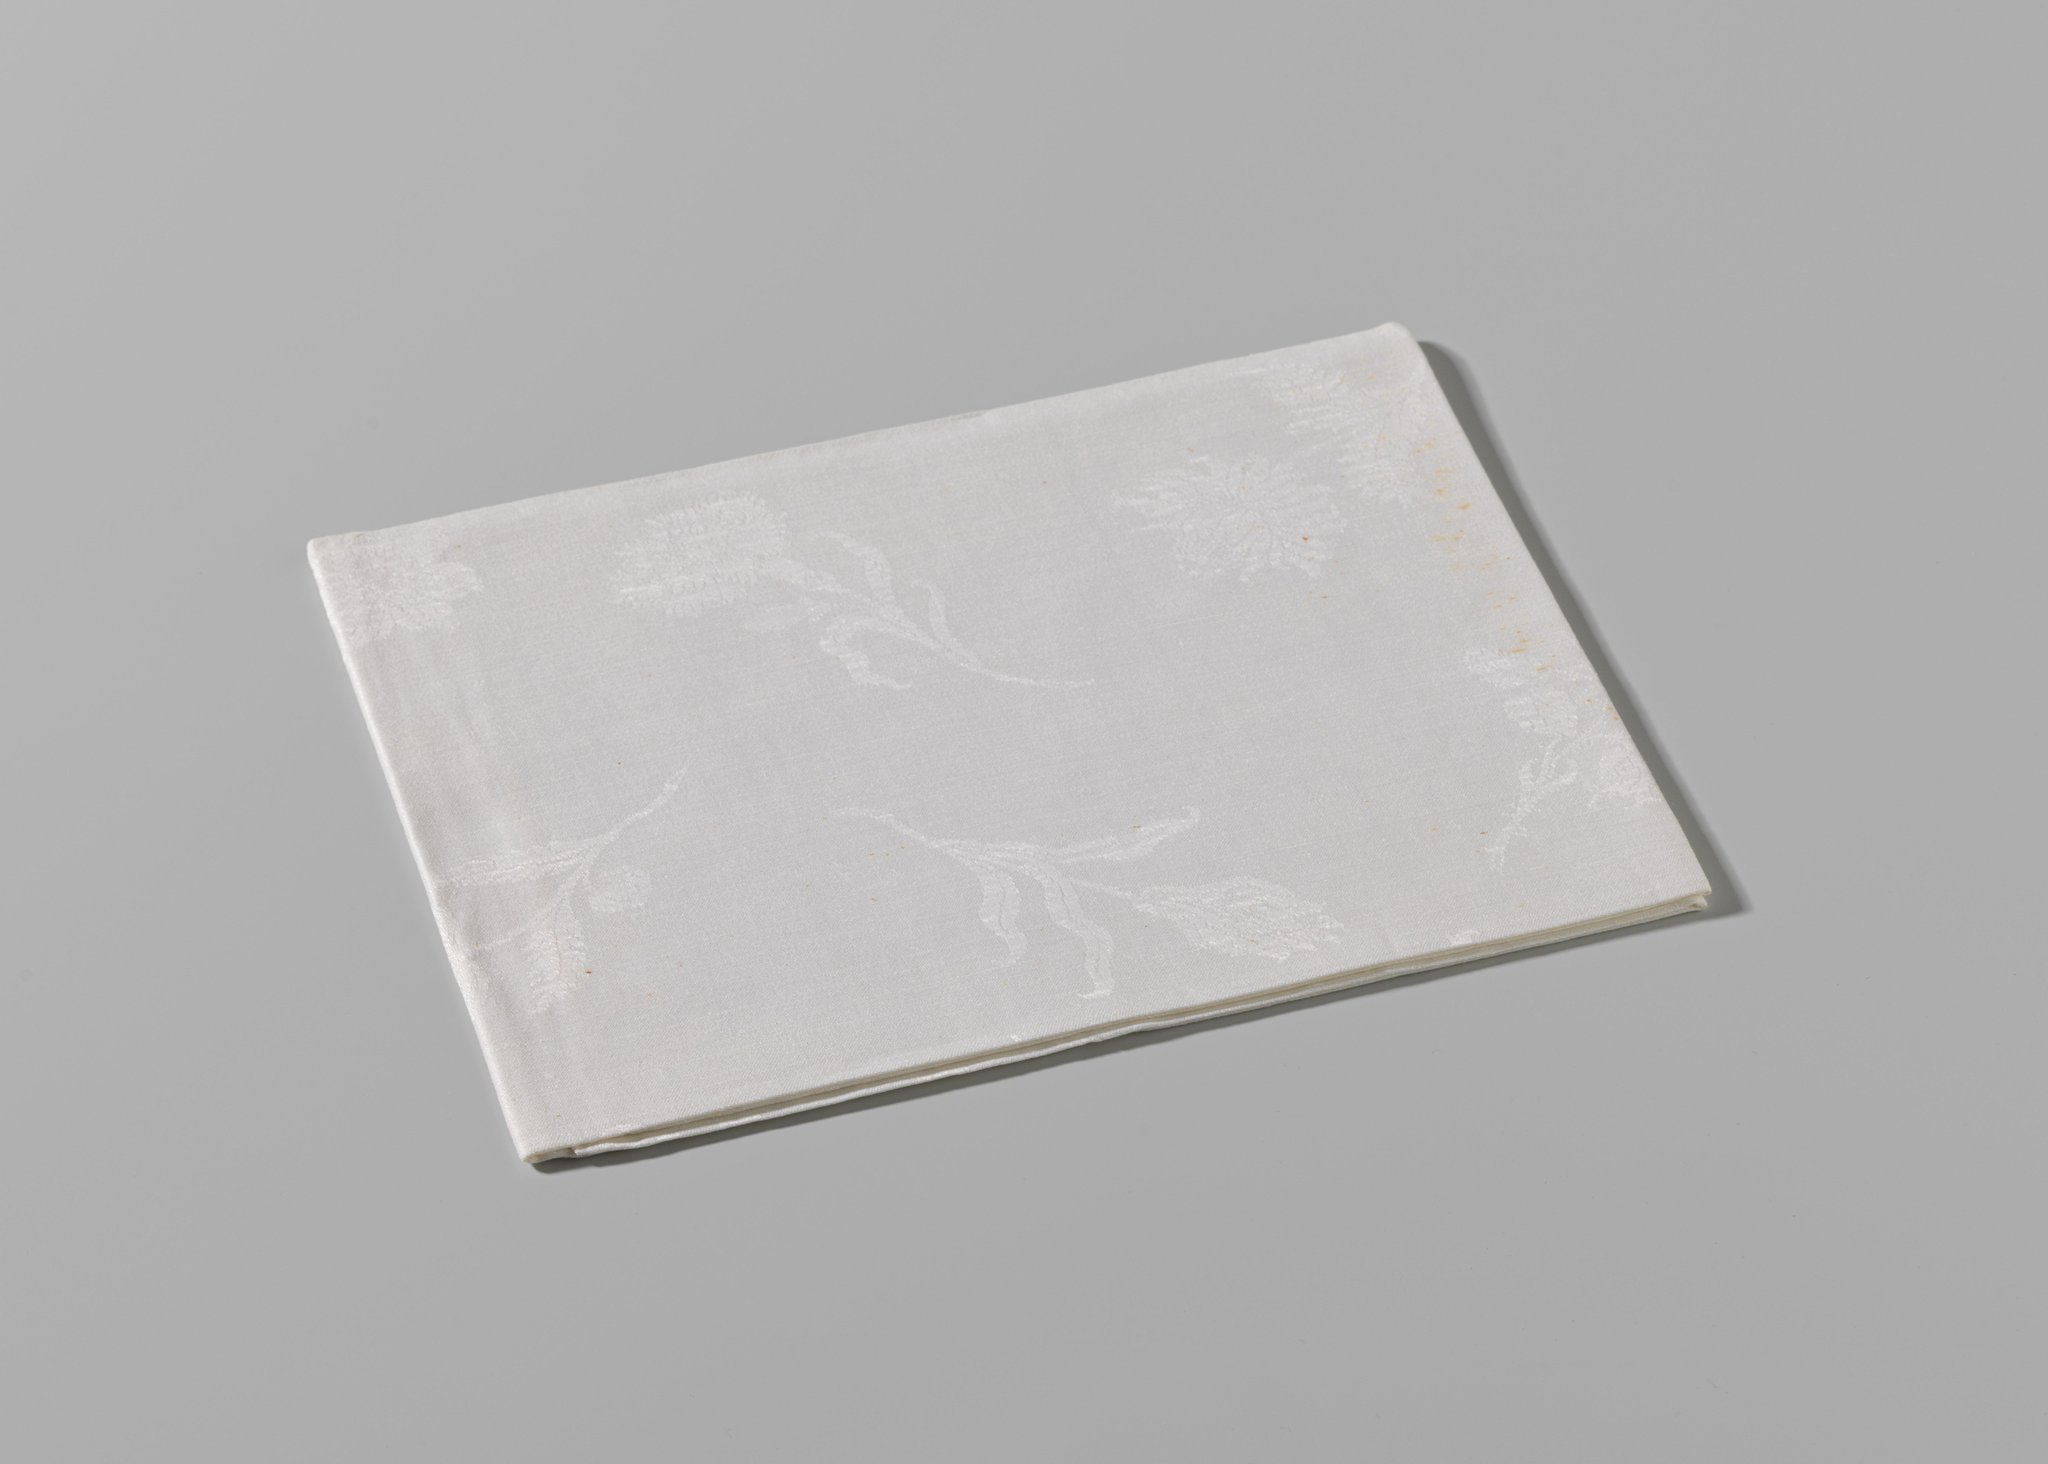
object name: napkin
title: Servet met een bloempatroon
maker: Anonymous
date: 1750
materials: linen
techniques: damask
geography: dresden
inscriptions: mark: ‘B’, mark: ‘21 of 25’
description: Servet van linnendamast met een bloempatroon. Onder andere: roos, ranonkel, lelietje van dalen, anjer, tulp; met stelen die schuin en in rijen tegengesteld gericht zijn. Staande rand: dunne lopende voluutranken, waaraan onder andere kelkbloemen, papaver, chrysant, akelei, en wordt begrensd door grote asymmetrische rocaillemotieven, die op de hoeken naar het midden zijn gericht. Rondom: blokkenrand.